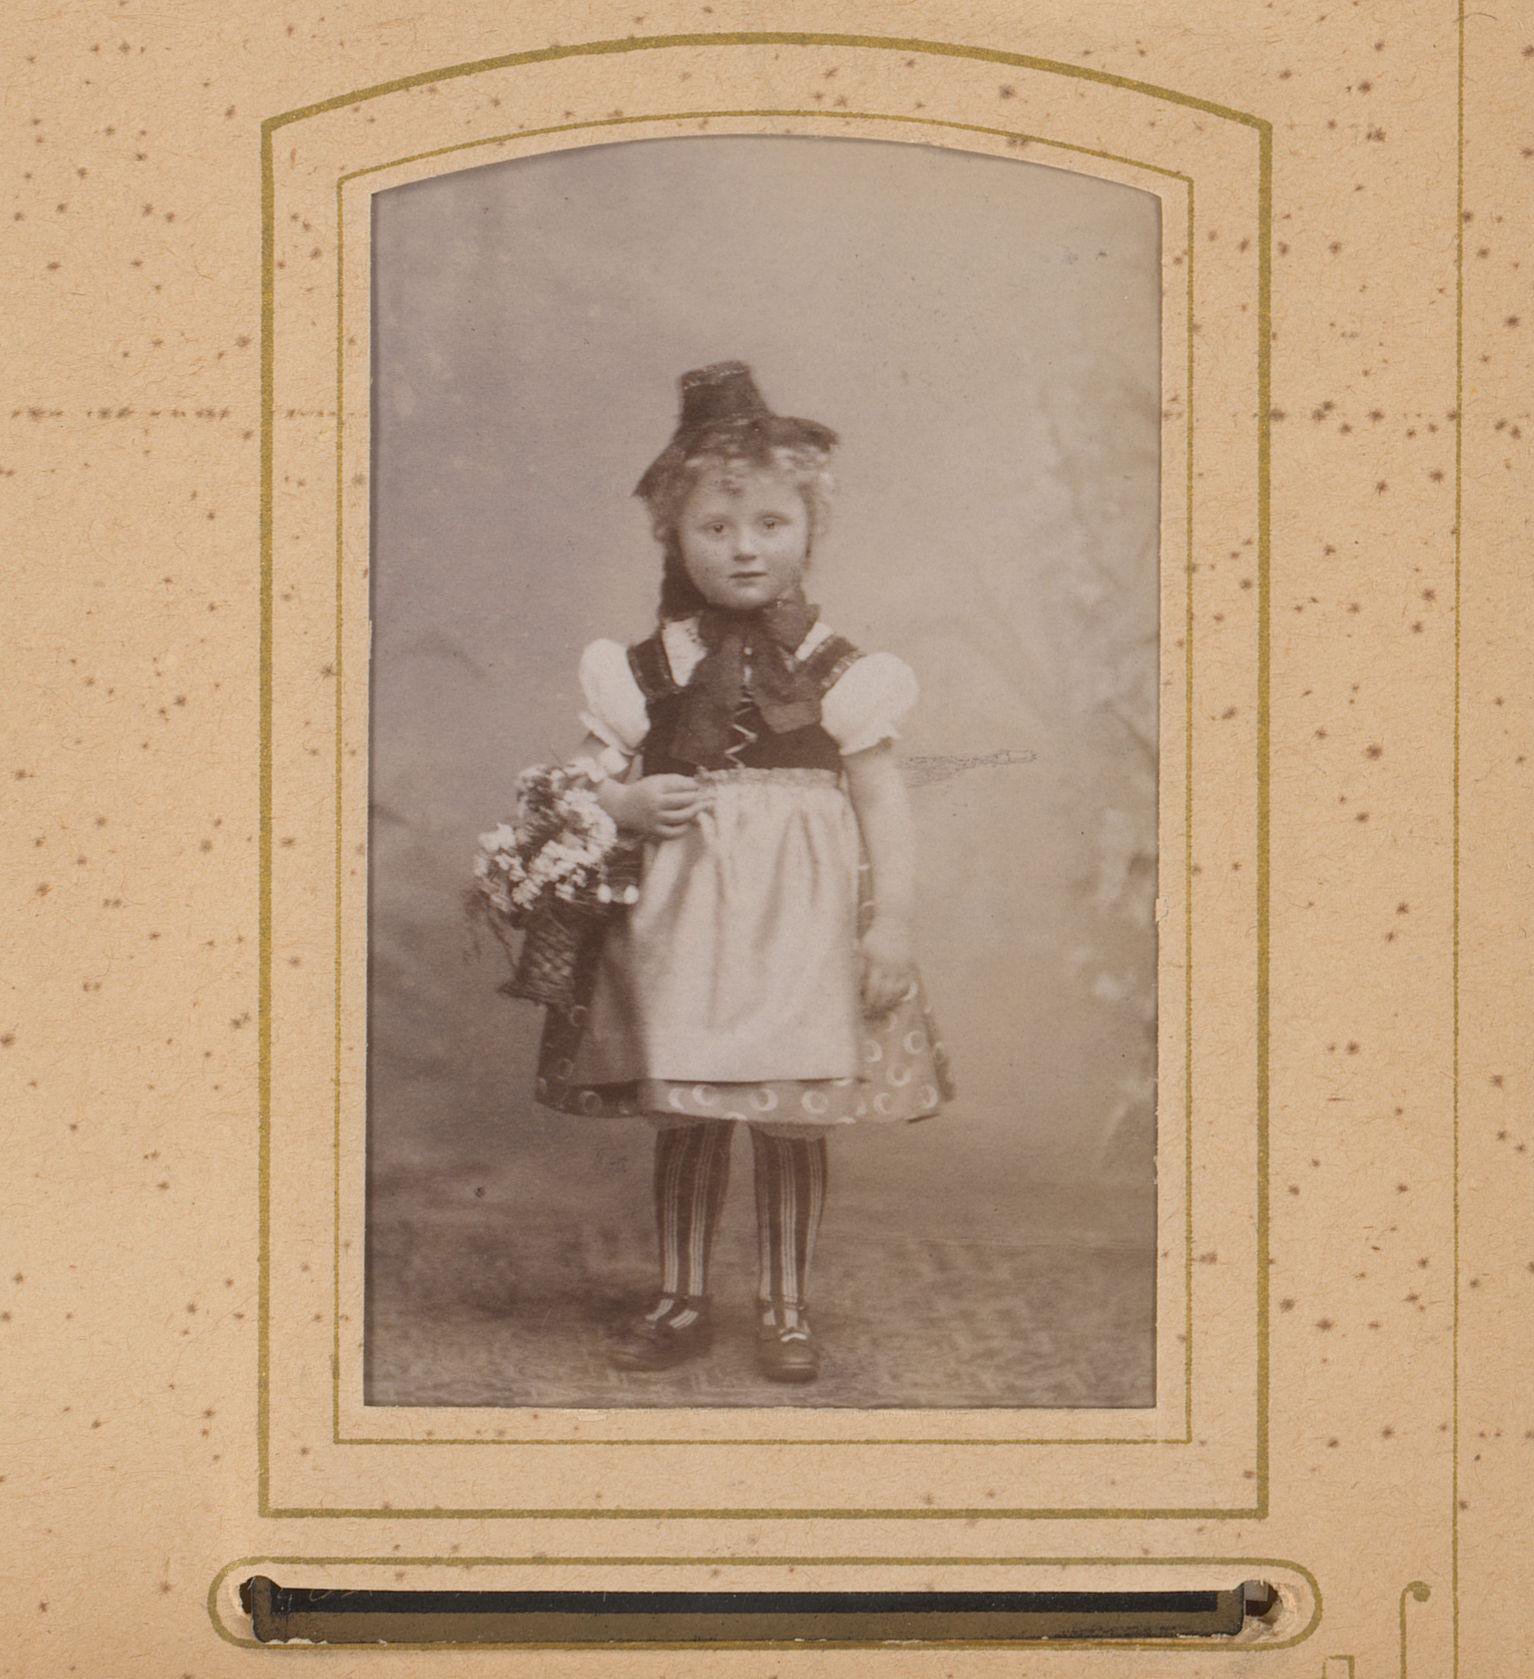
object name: photograph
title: Portret van een meisje met mand bloemen in de hand, aangeduid als Elsa Leybald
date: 1802-1888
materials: cardboard, photographic support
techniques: albumen print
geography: augsburg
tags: flowers, historical persons - bb - woman, container made of plant material other than wood: basket, toddler (female)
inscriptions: annotation: ‘Februar 88 2 Jahre 9 Mn.’, inscription: ‘Atelier/ für/ Fotografie/ von/ Gebr. Voisard/ in/ Augsburg./ Fuggerstr. u. Grottenau./ Nachbestellungen und Vergrösserungen werden bestens/ effectuirt.’, name: ‘Elsa Leybald Ang[...]g’